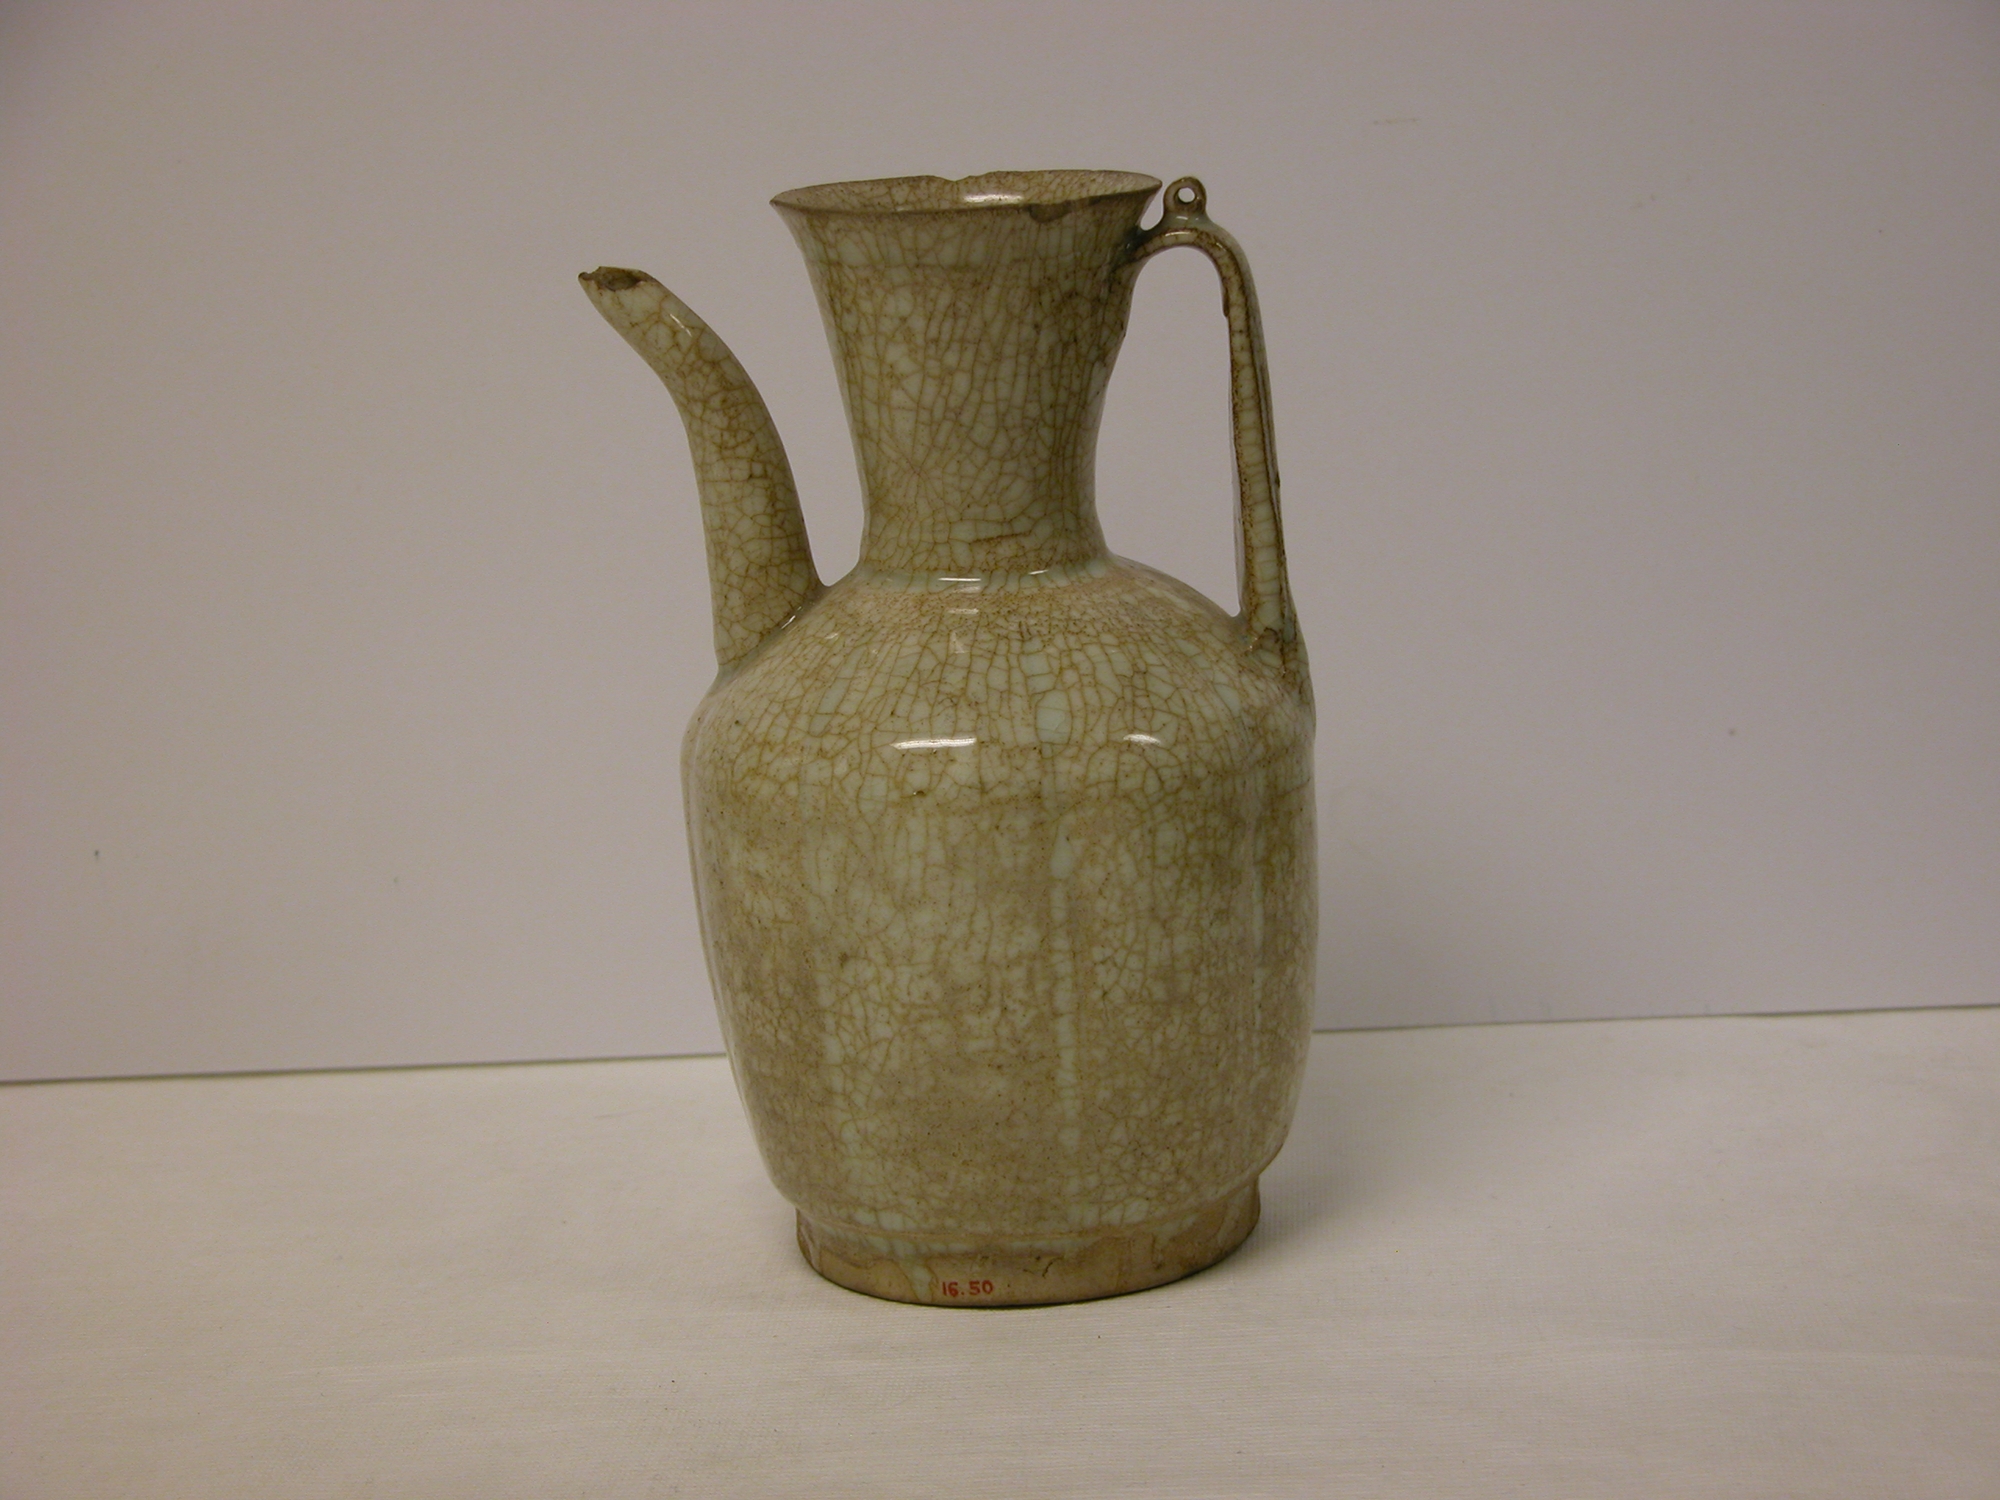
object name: wine jug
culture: chinese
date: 960-1279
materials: pottery